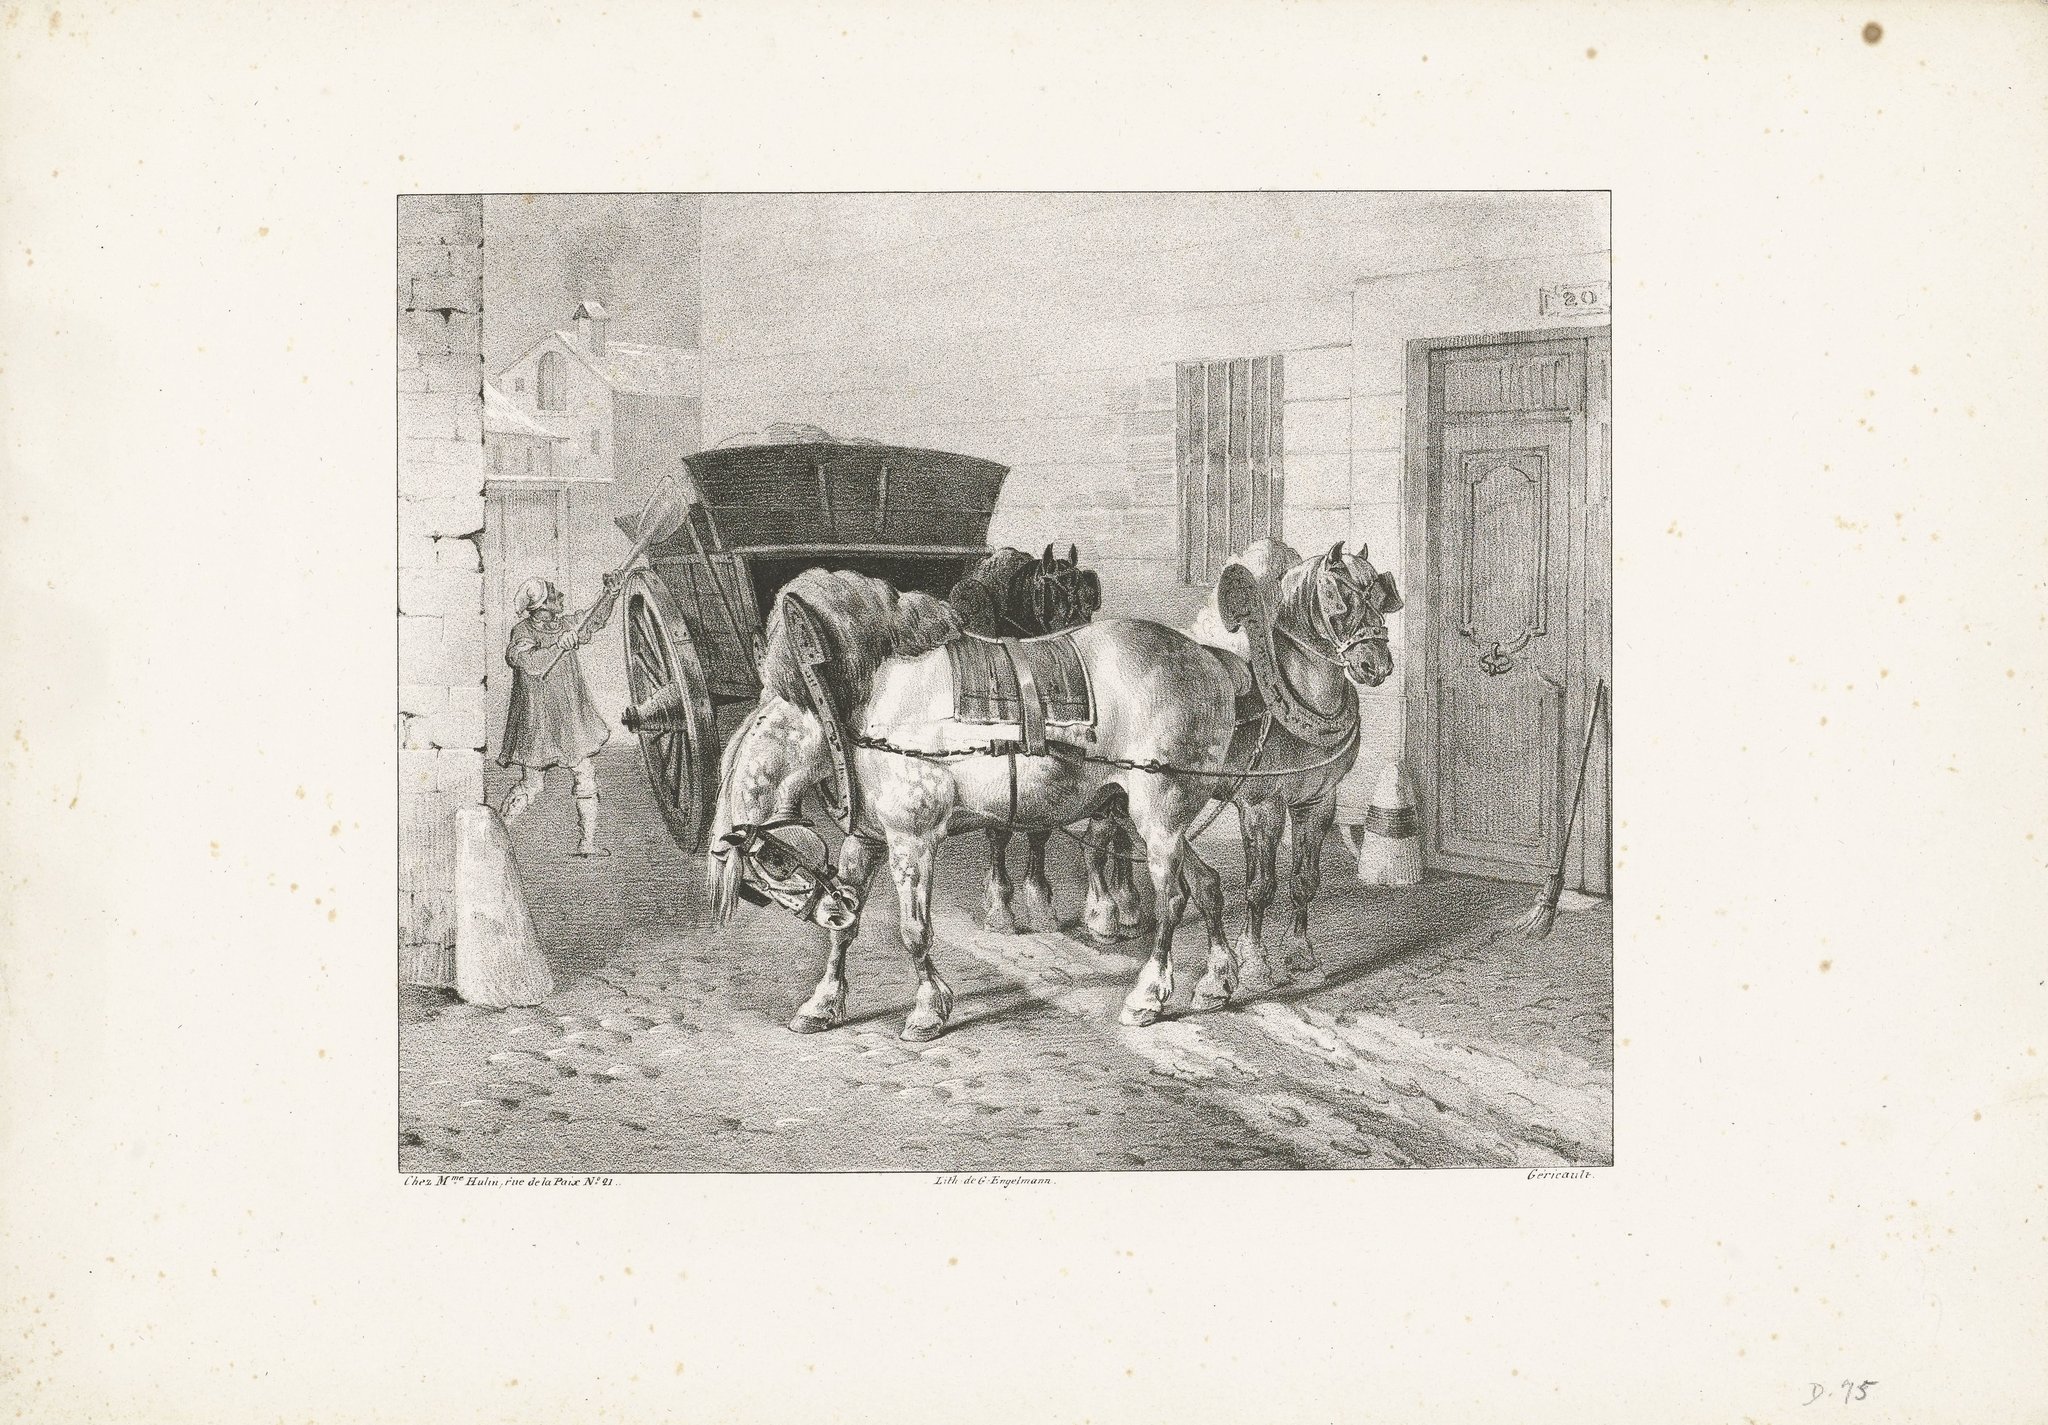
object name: print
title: Straatveger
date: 1823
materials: paper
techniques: lithograph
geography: paris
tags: collecting the rejected parts, horse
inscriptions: collector's mark: Lugt 2228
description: Een man schept de vuilnis in zijn wagen. Voor de wagen zijn drie trekpaarden gespannen.